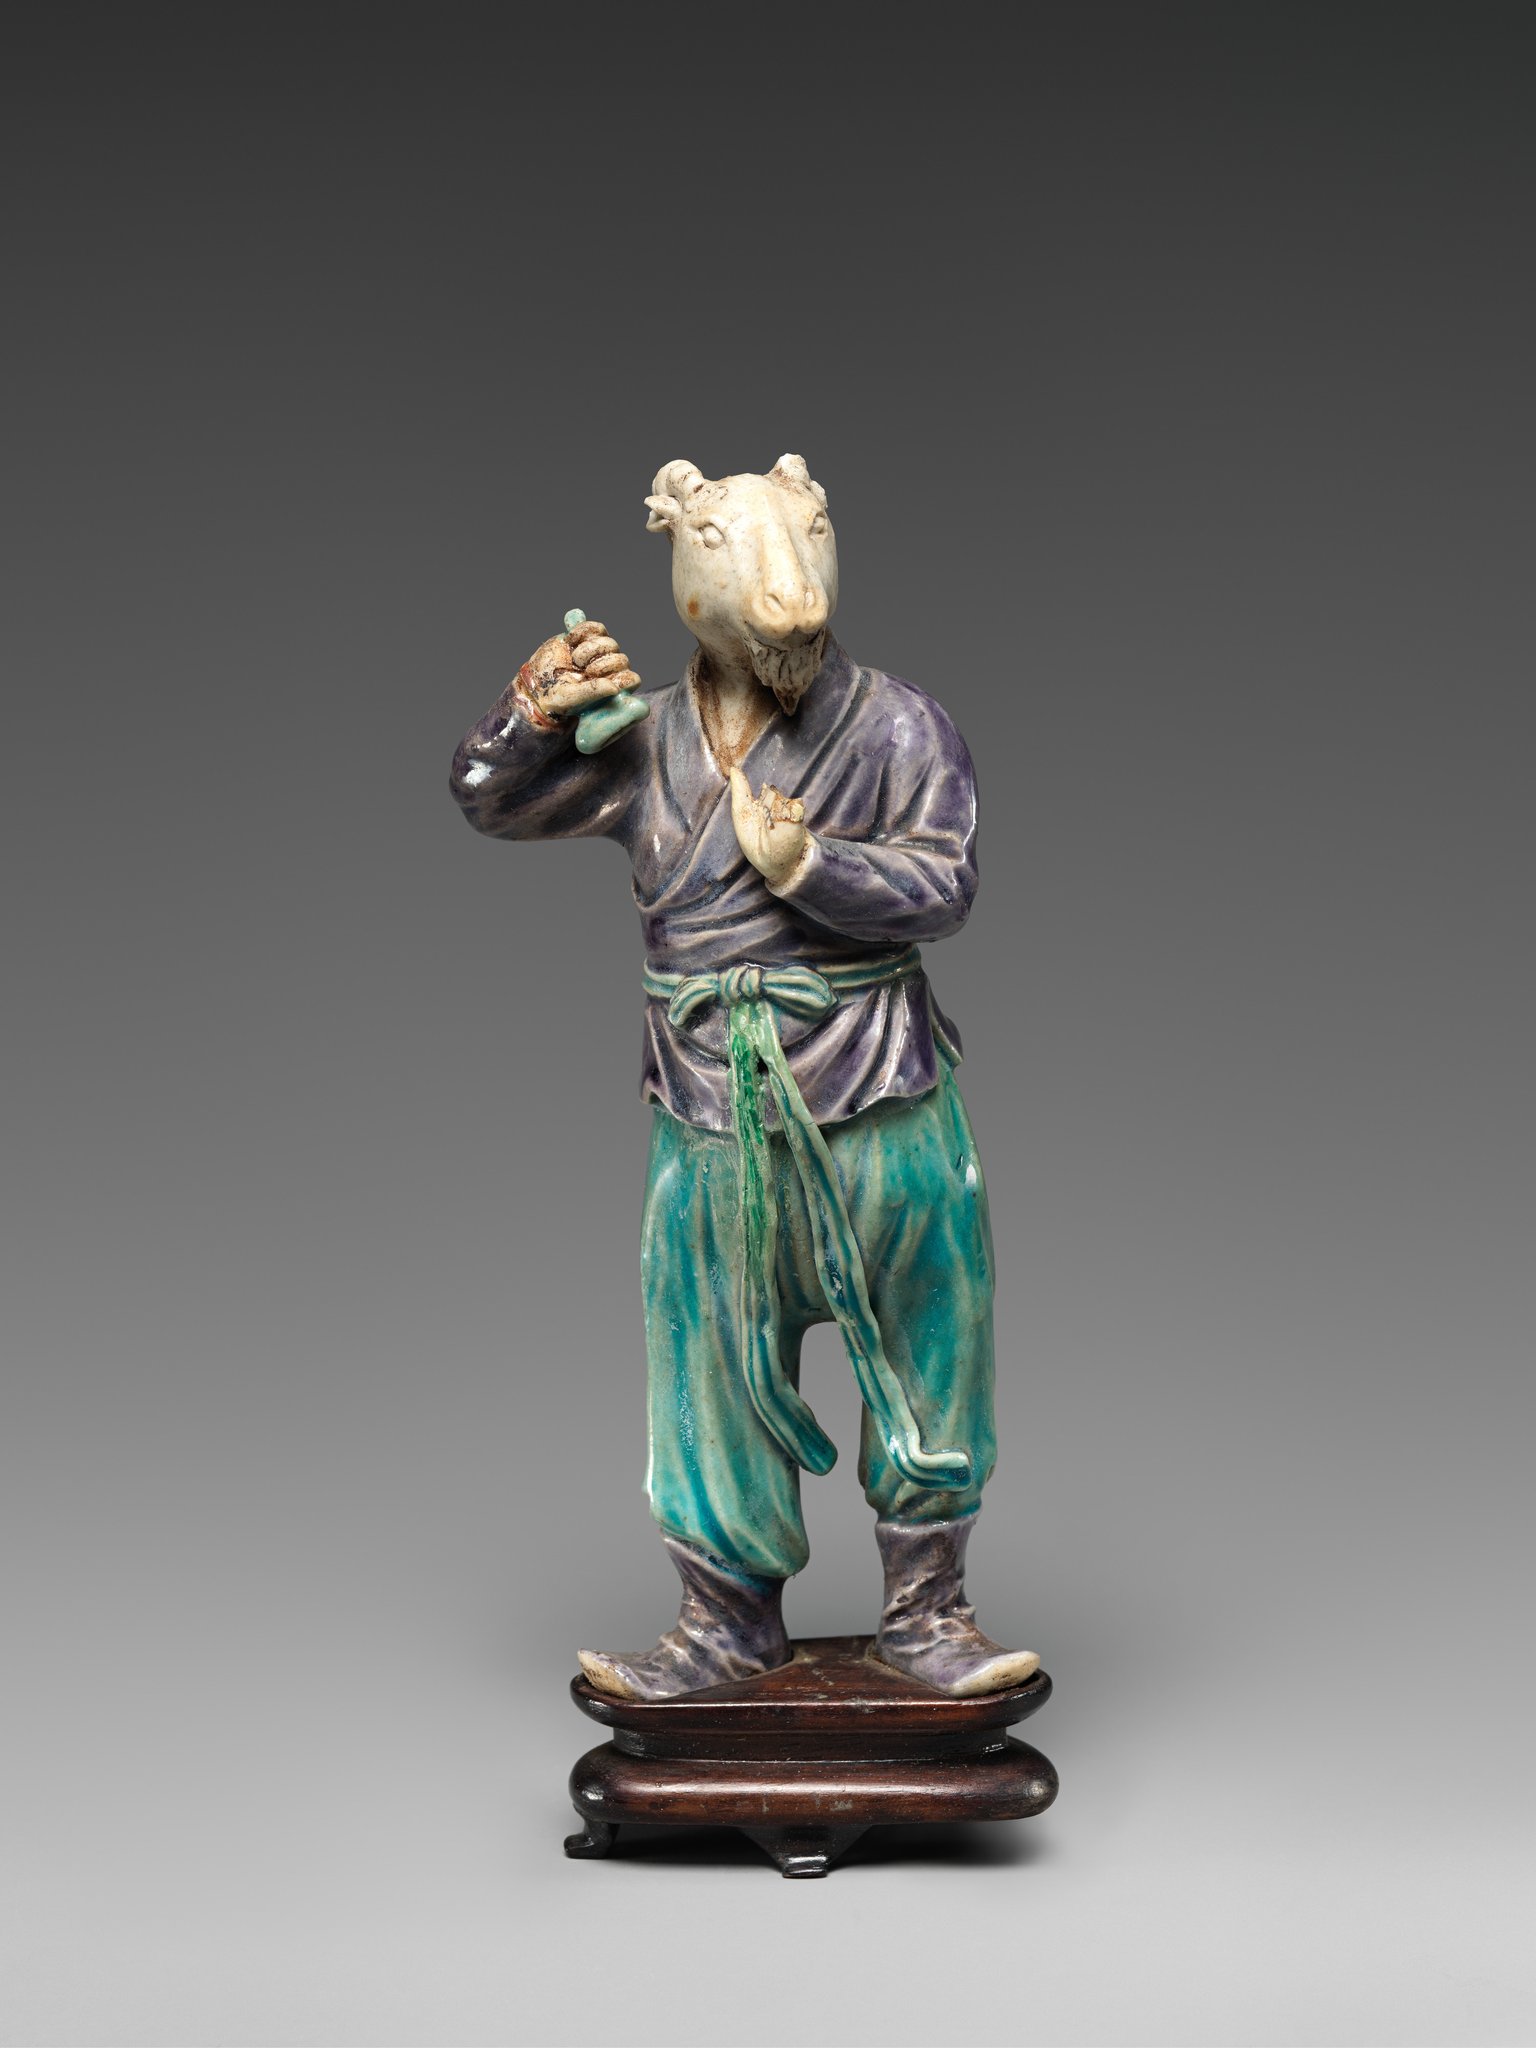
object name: figure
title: Zodiac figure: goat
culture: chinese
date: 1701-1800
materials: biscuit, glaze, porcelain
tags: mythical creatures,goats,zodiac